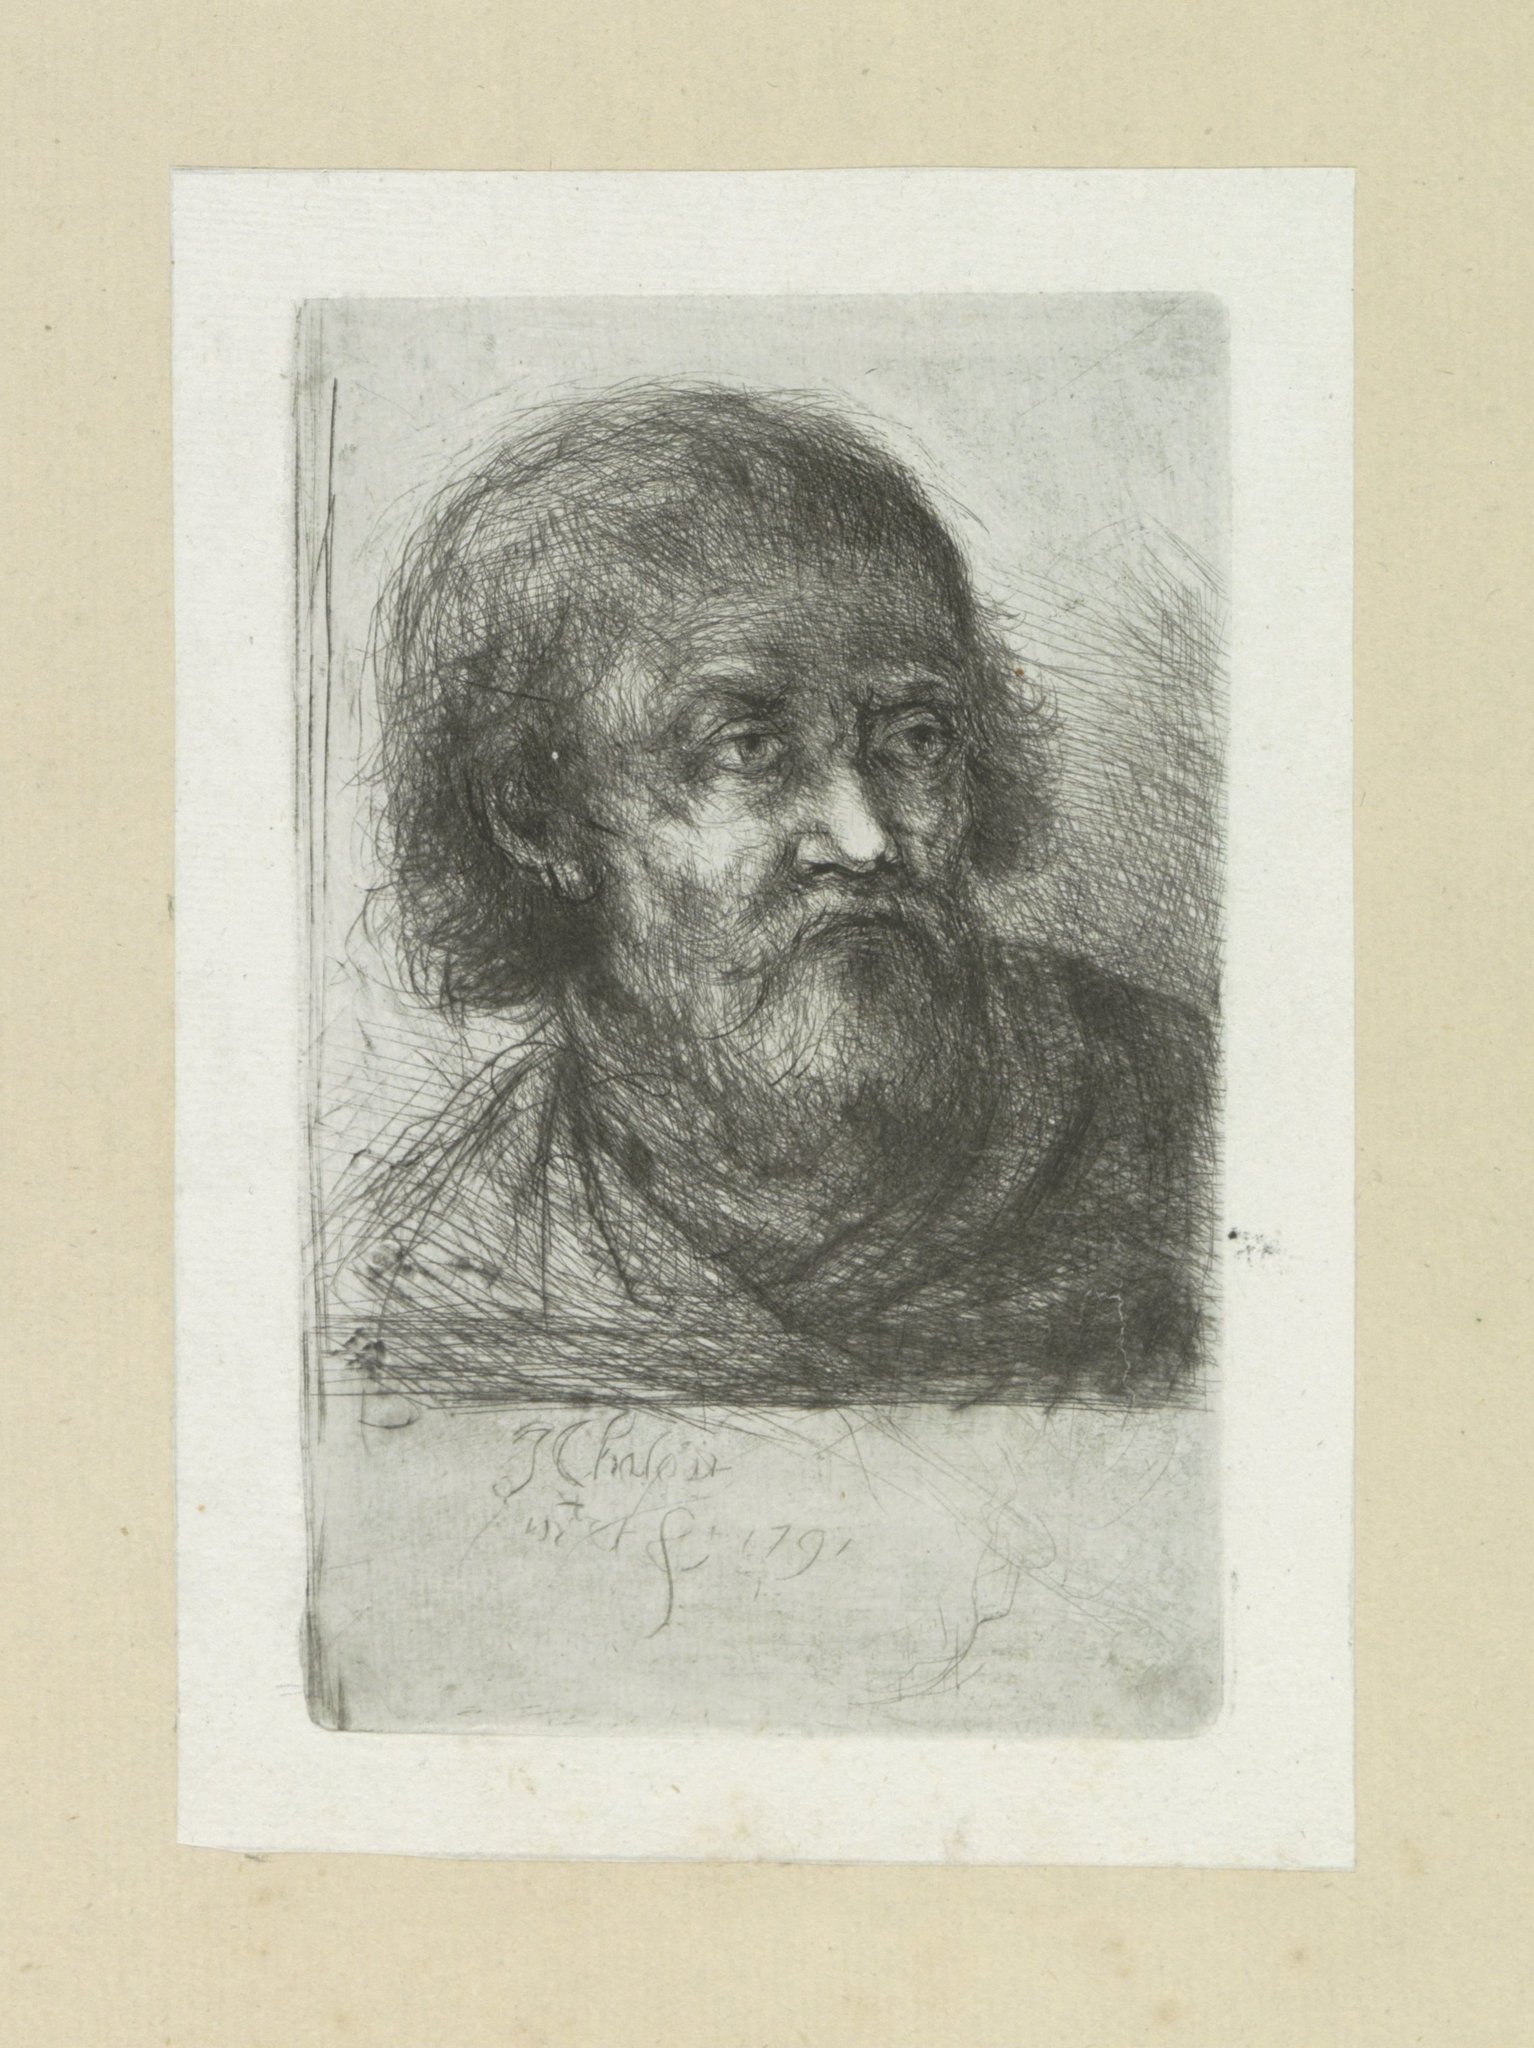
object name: print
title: The Compleat Work of Etchings by John Chalon / Oeuvre Complette des Eaux Fortes par Jean Chalon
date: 1791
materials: paper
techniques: drypoint, etching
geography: london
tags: morphology of human expression (+ old male (human being))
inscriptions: collector's mark: ‘RIJKS / MUSM’, collector's mark: ‘B’